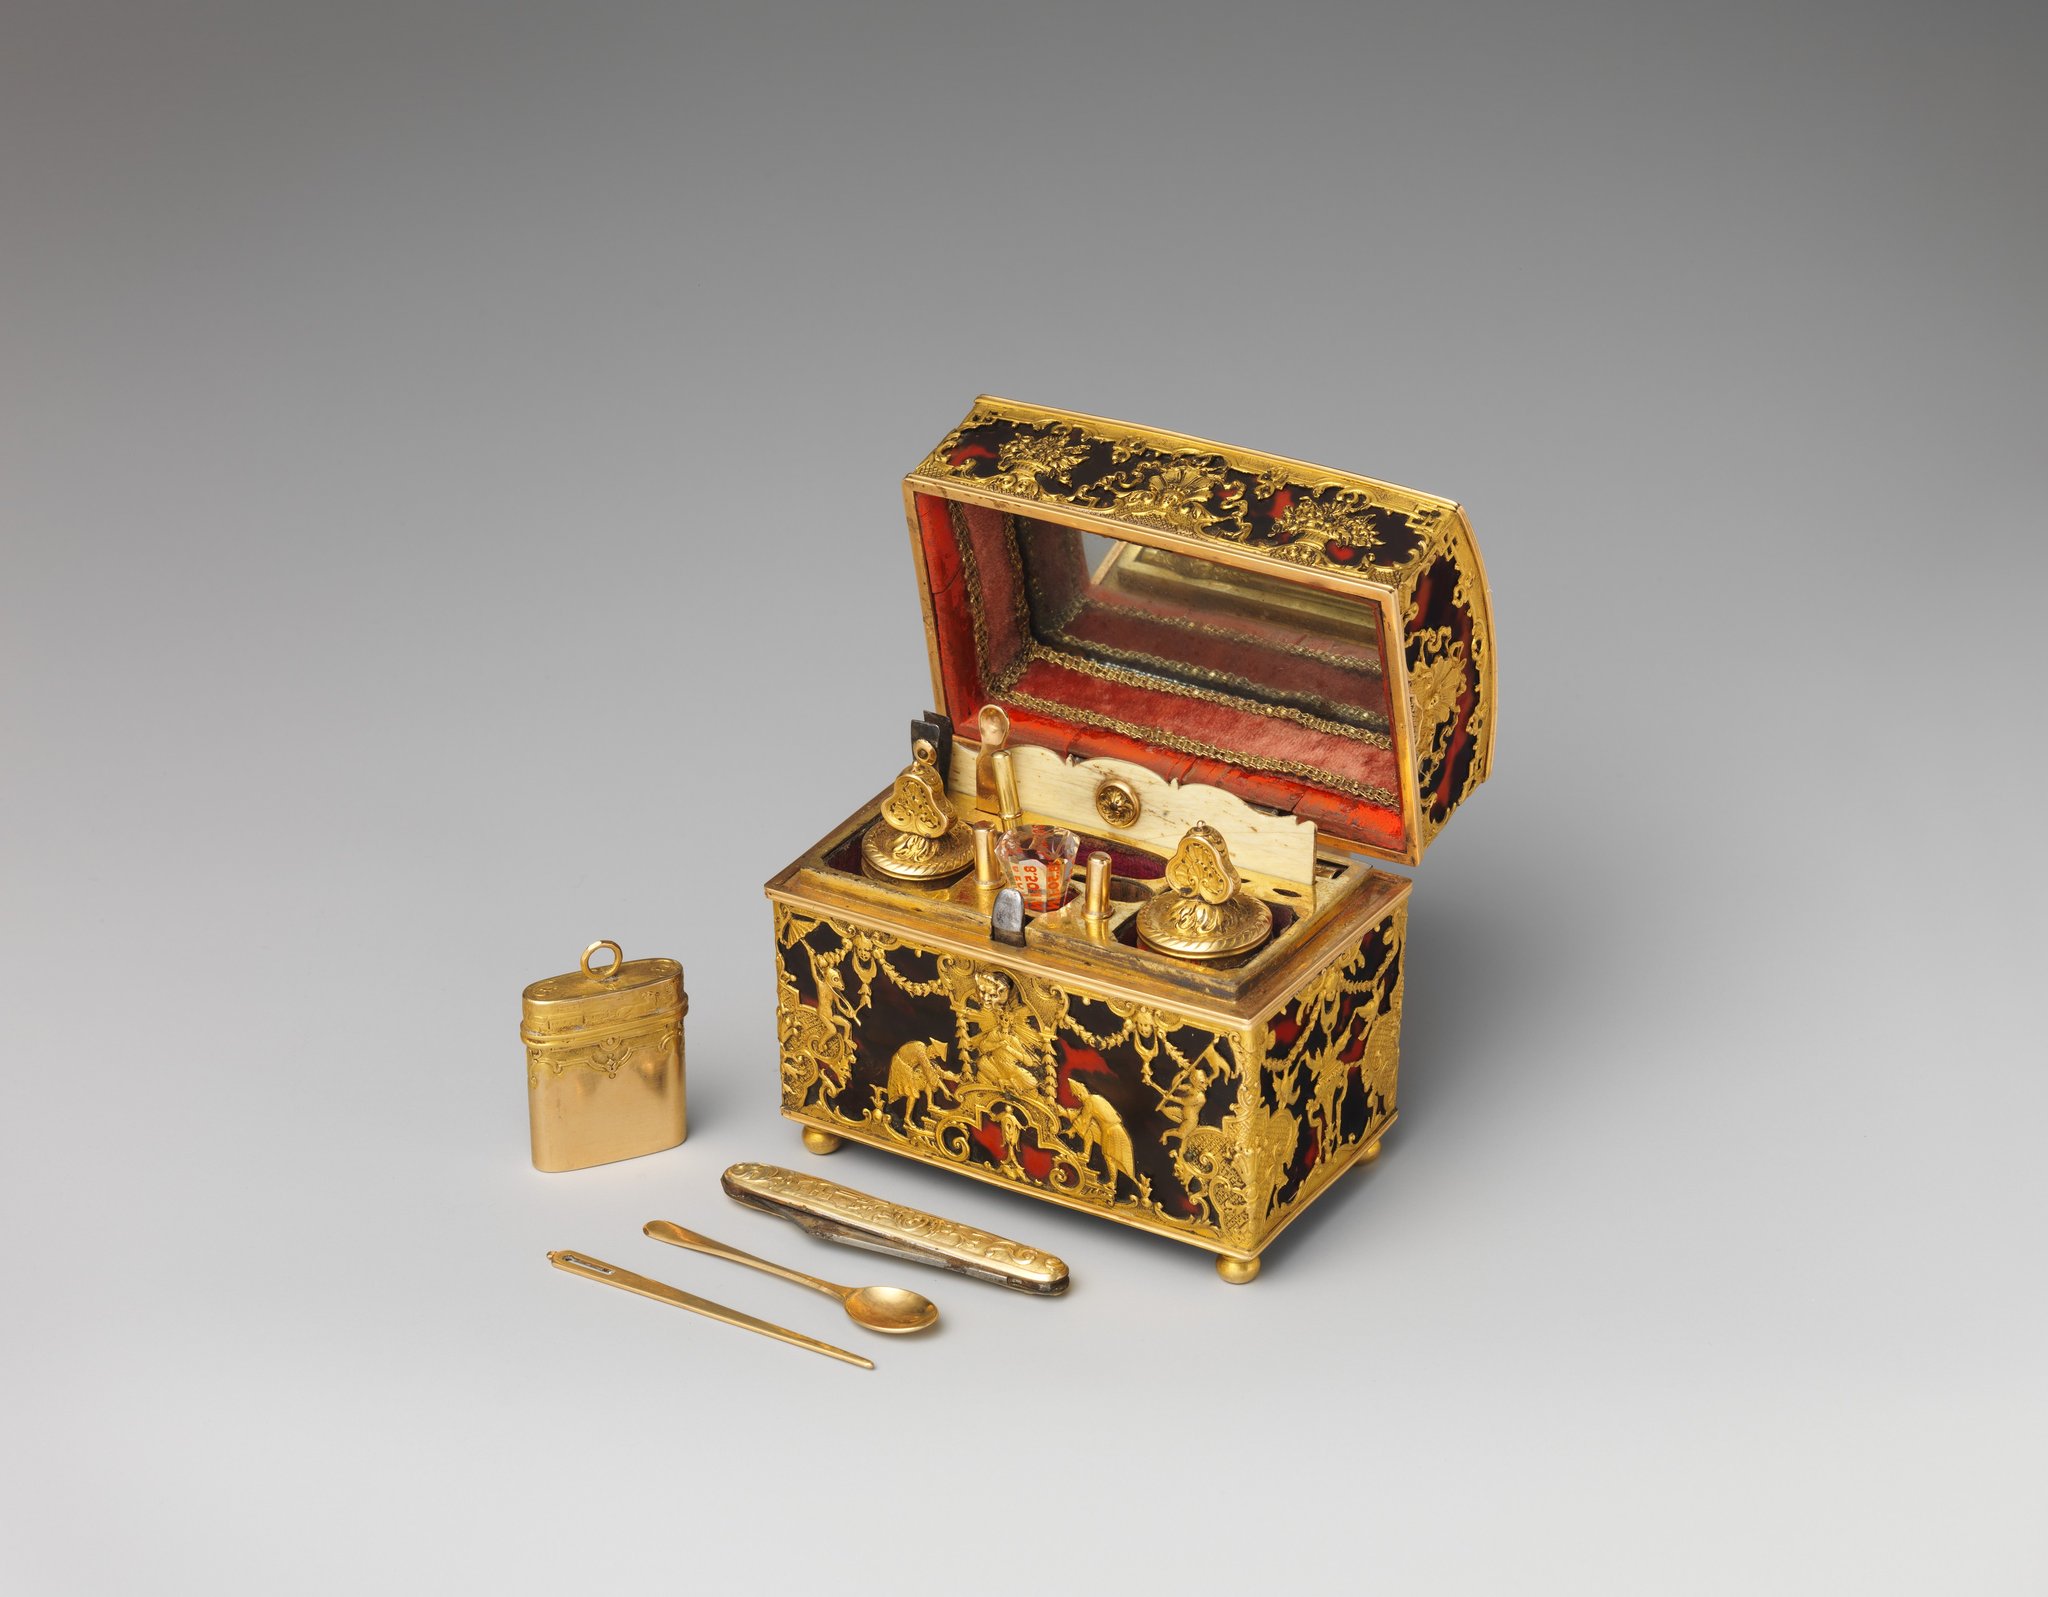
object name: nécessaire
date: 1701-1725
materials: glass, gold, ivory, shell, wood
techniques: veneering